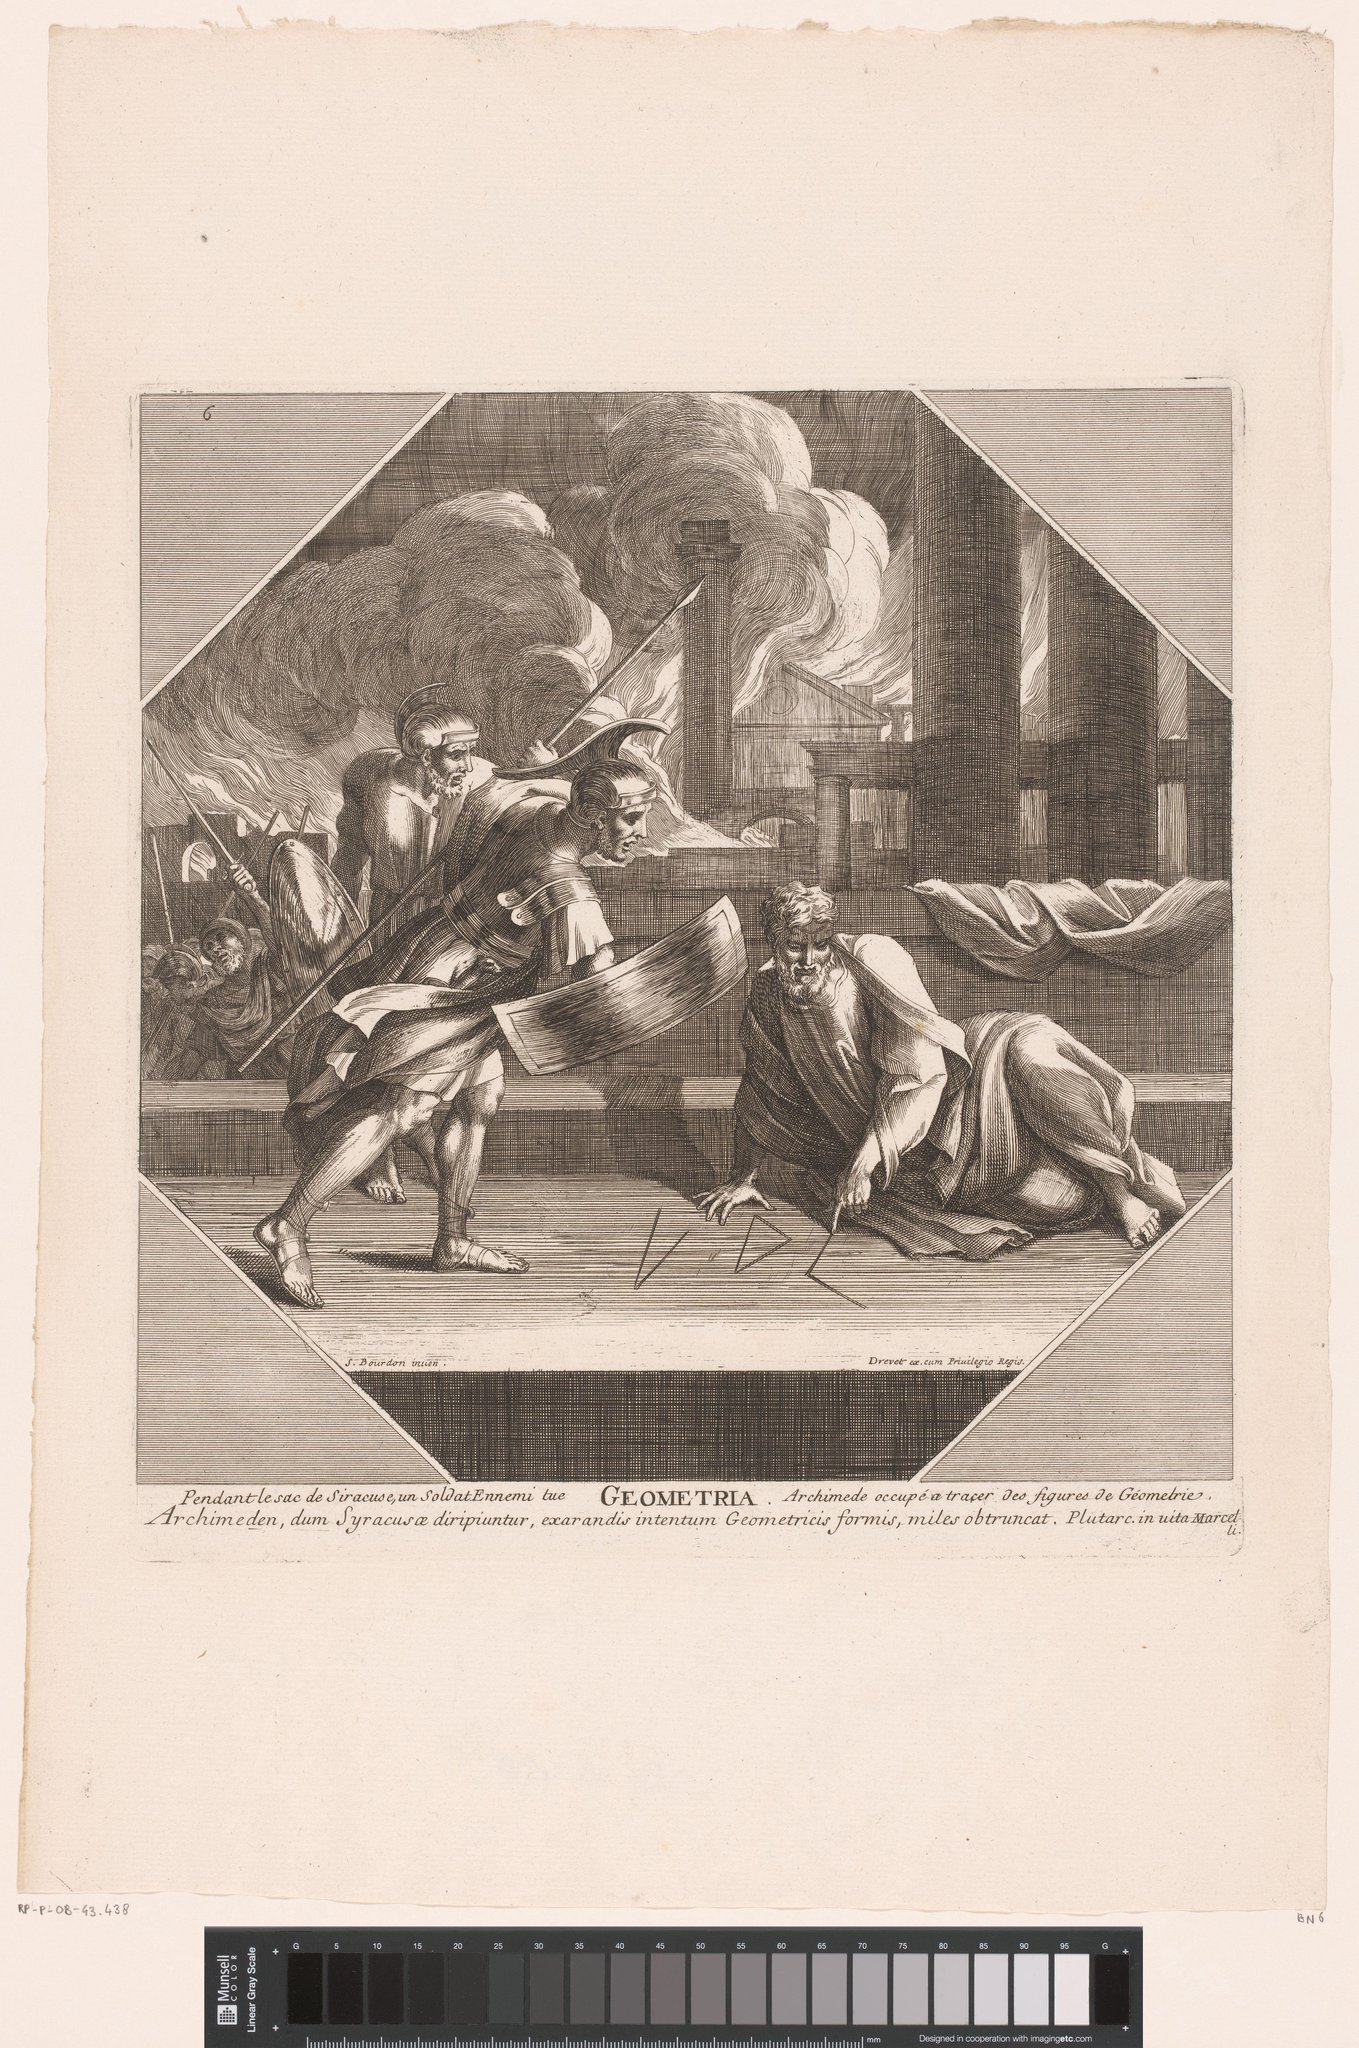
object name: print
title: Geometria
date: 1663-1738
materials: paper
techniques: engraving, etching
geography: paris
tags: physicist, 'geometria' (~ quadrivium); 'geometria' (ripa), historical persons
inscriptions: collector's mark: Lugt 2228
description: Maakt deel uit van een veertiendelige serie opgedeeld in twee reeksen, met als onderwerp de zeven vrije kunsten en deugden naar schilderijen door Sébastien Bourdon. De schilderijen werden in 1663 vervaardigd voor de Grande Galerie van het Hôtel de Bretonvilliers te Parijs.